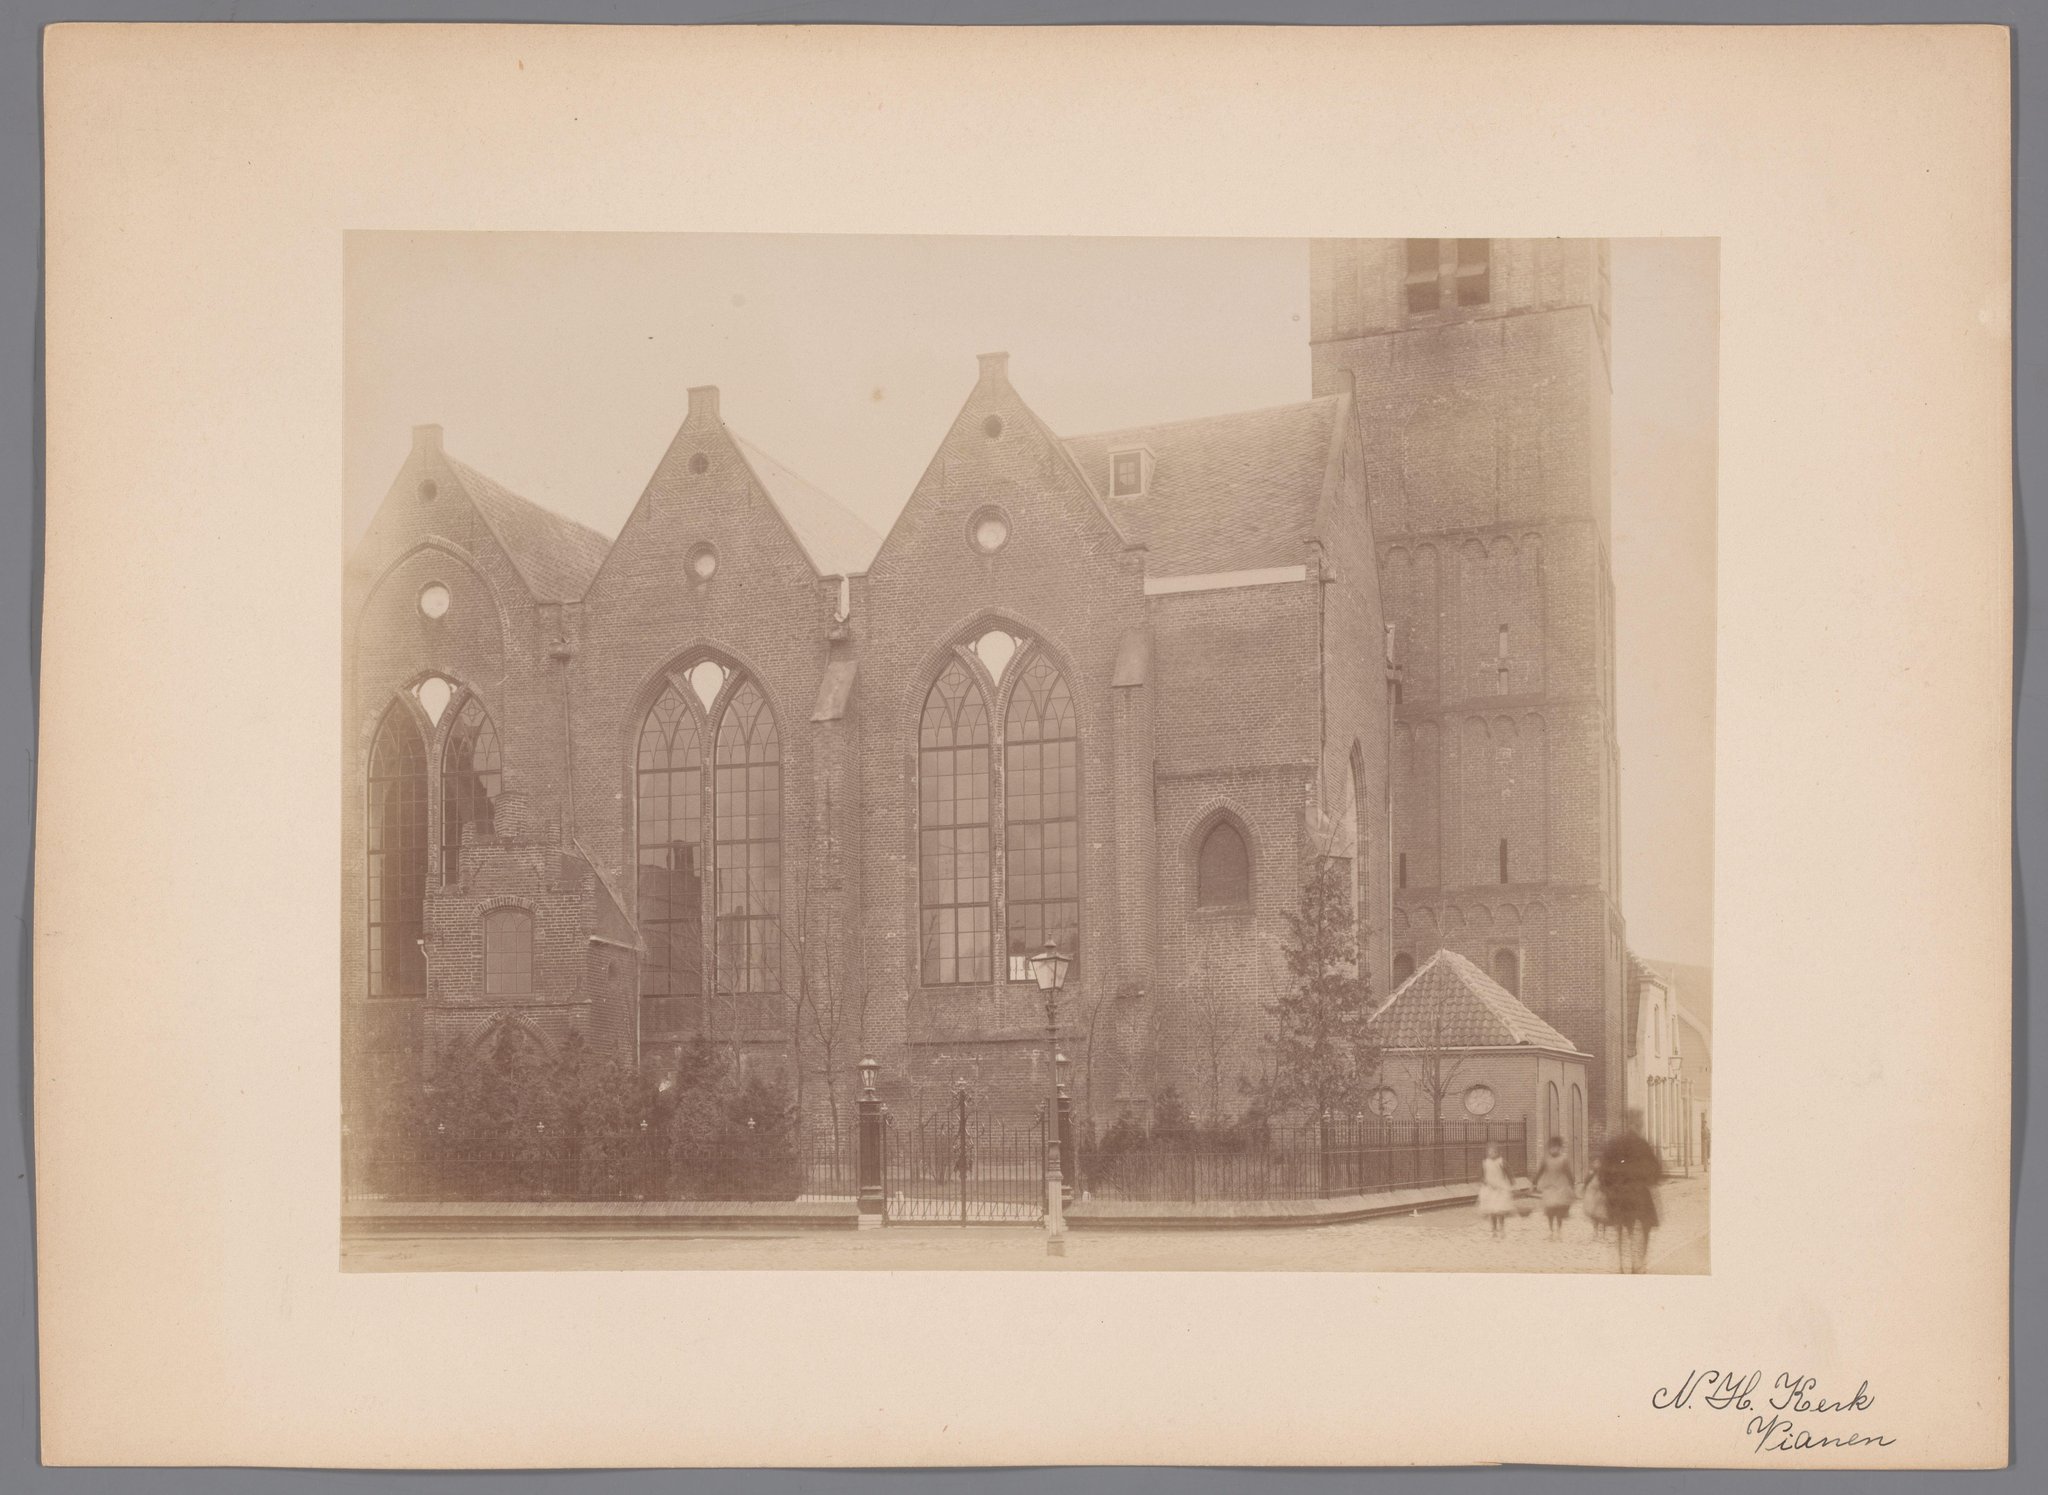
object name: photograph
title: Noordzijde van de Grote Kerk te Vianen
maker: anoniem (monumentenzorg)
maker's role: fotograaf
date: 1890-1920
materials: cardboard, photographic support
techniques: albumen print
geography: vianen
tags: church (exterior)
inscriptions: annotation: ‘N.H. Kerk/ Vianen’, annotation: ‘Vianen/ N.H. Kerk’